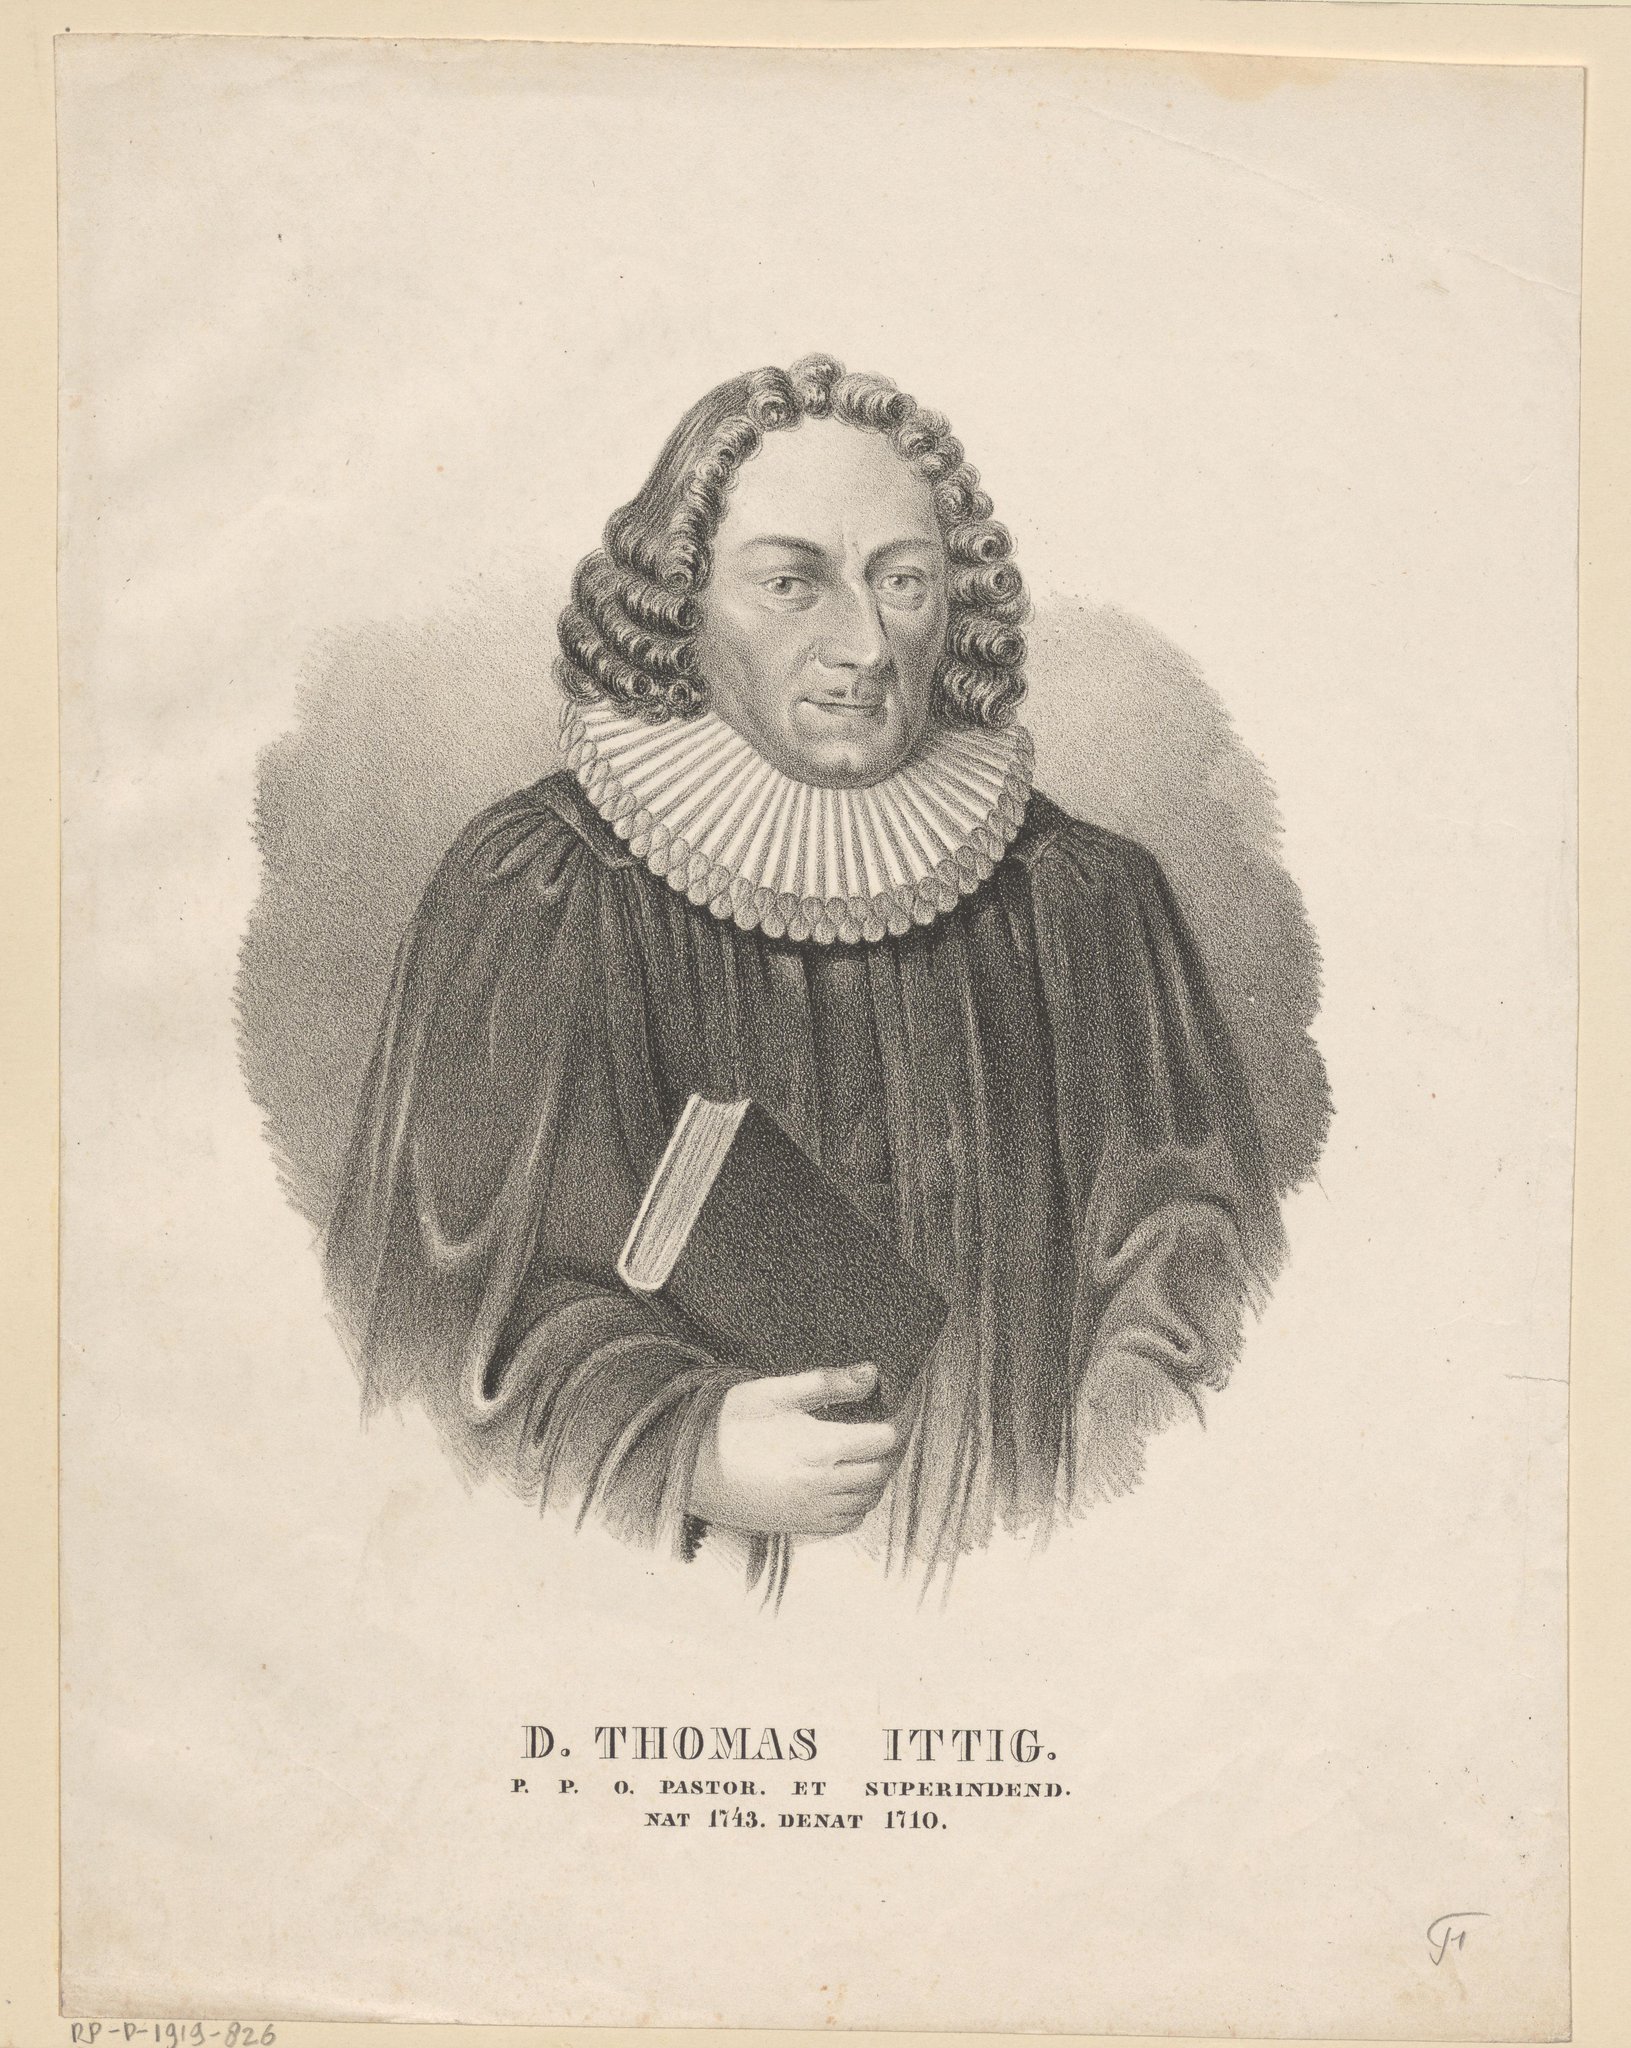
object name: print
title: Portret van Thomas Ittig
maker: Anonymous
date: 1800-1849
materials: paper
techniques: lithograph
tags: thomas ittig, theologian, historical persons, book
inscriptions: collector's mark: Lugt 2228